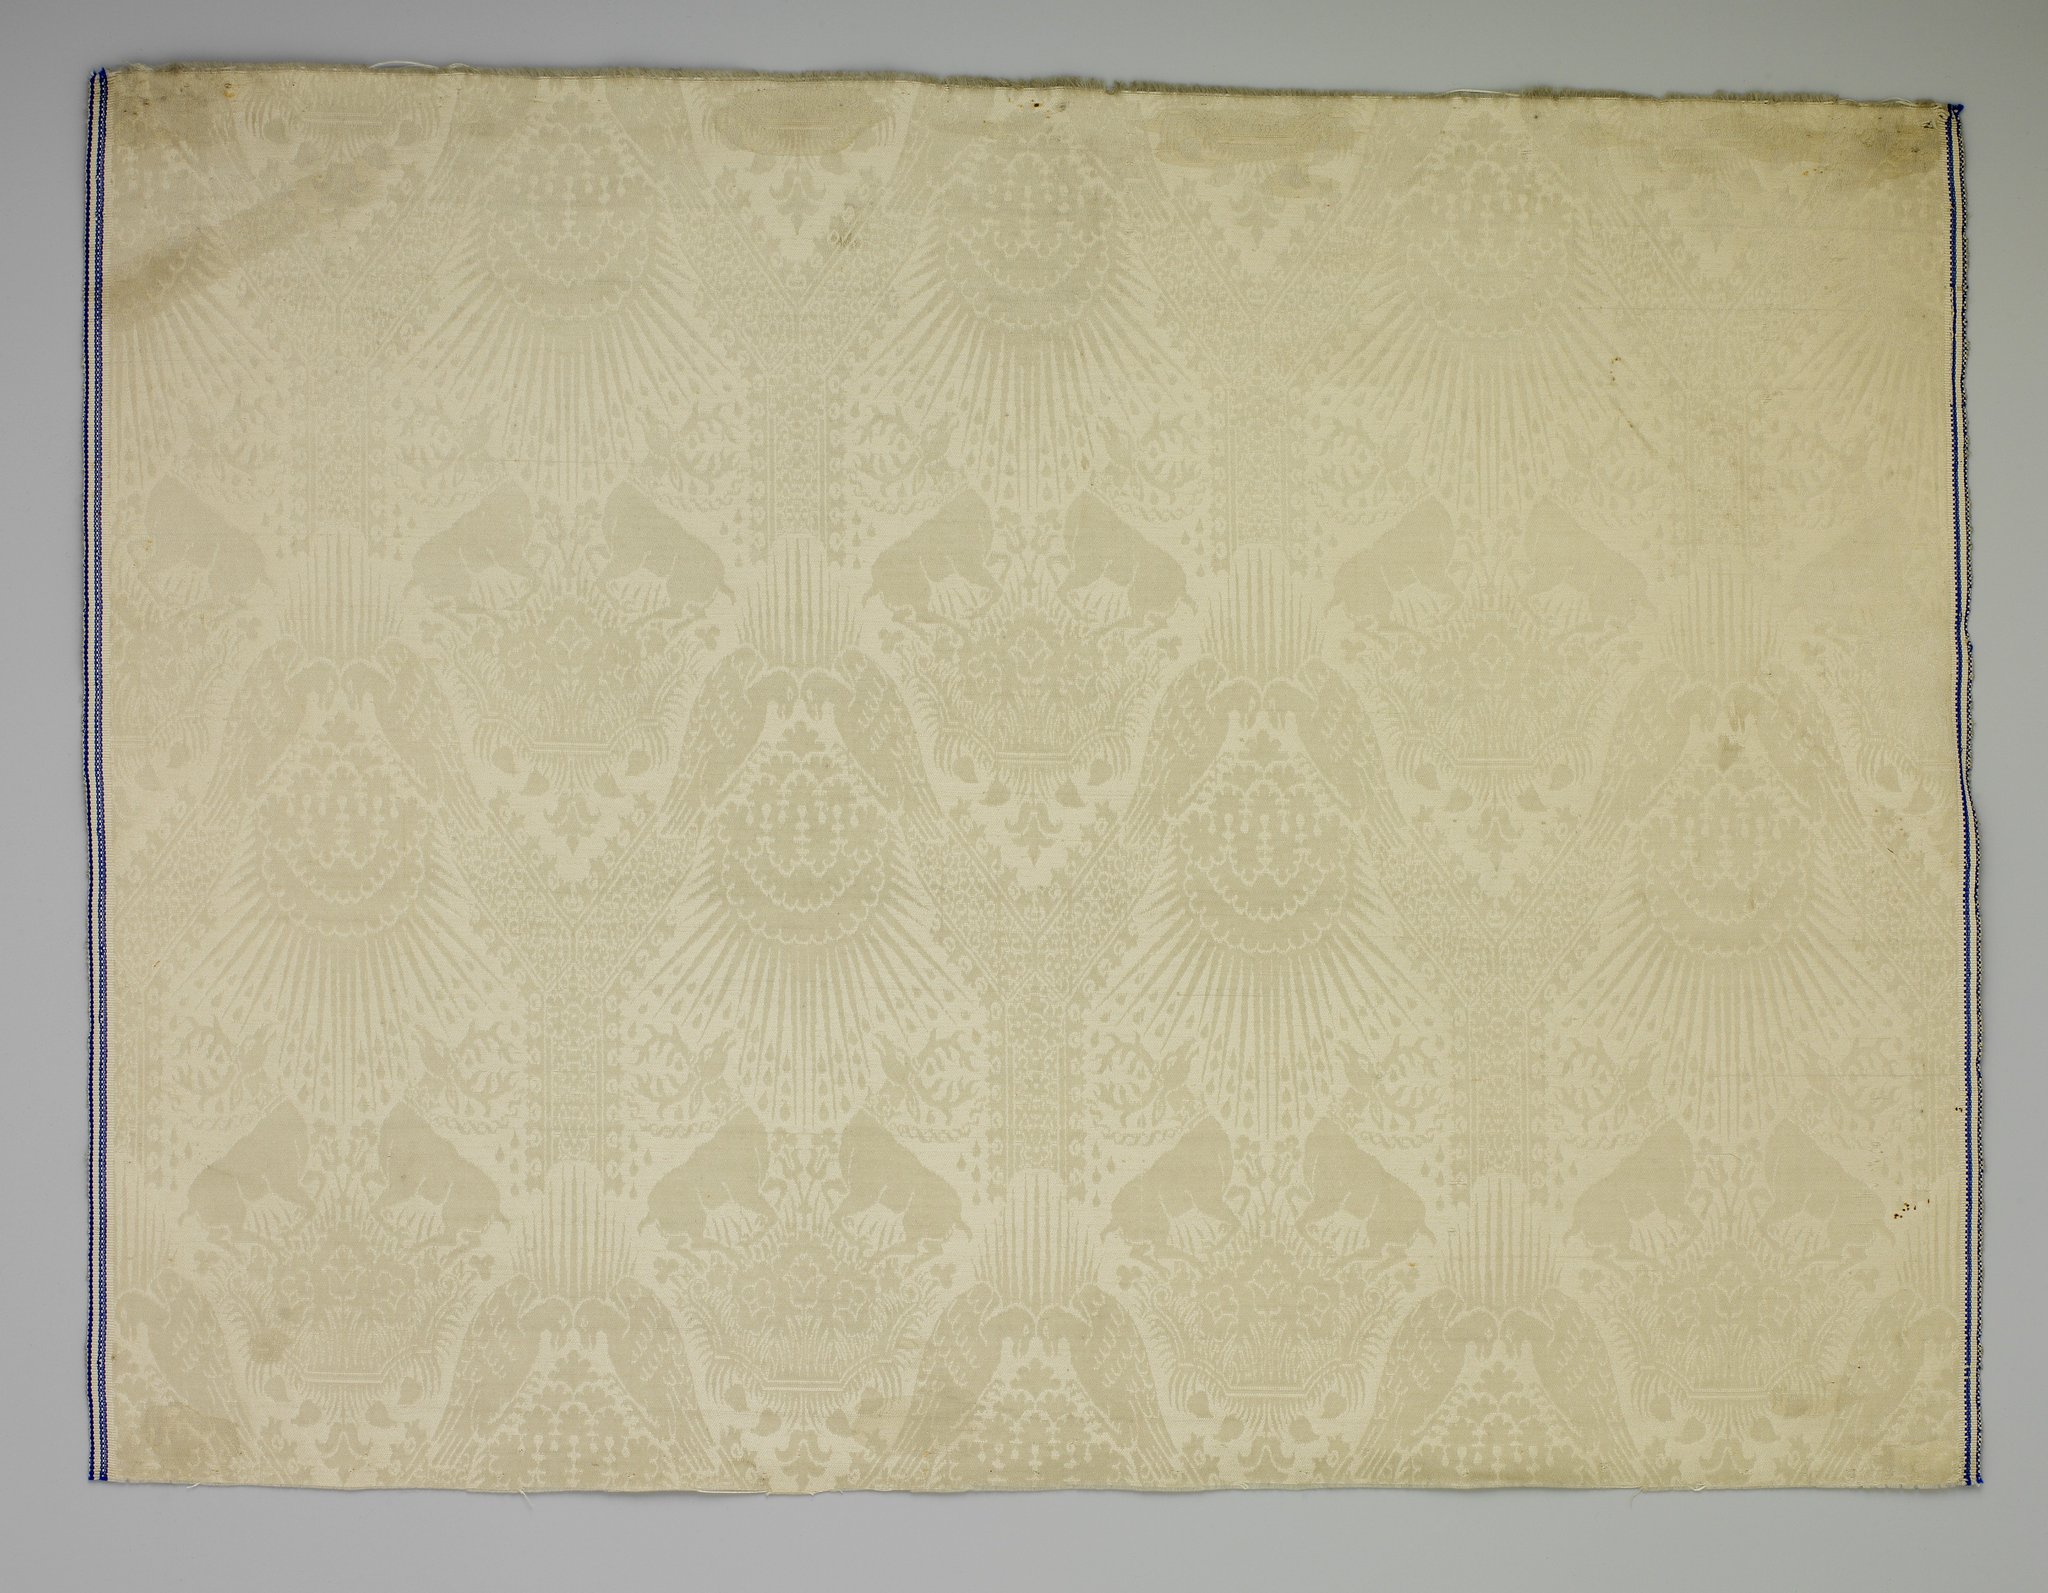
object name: piece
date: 1851-1900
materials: silk